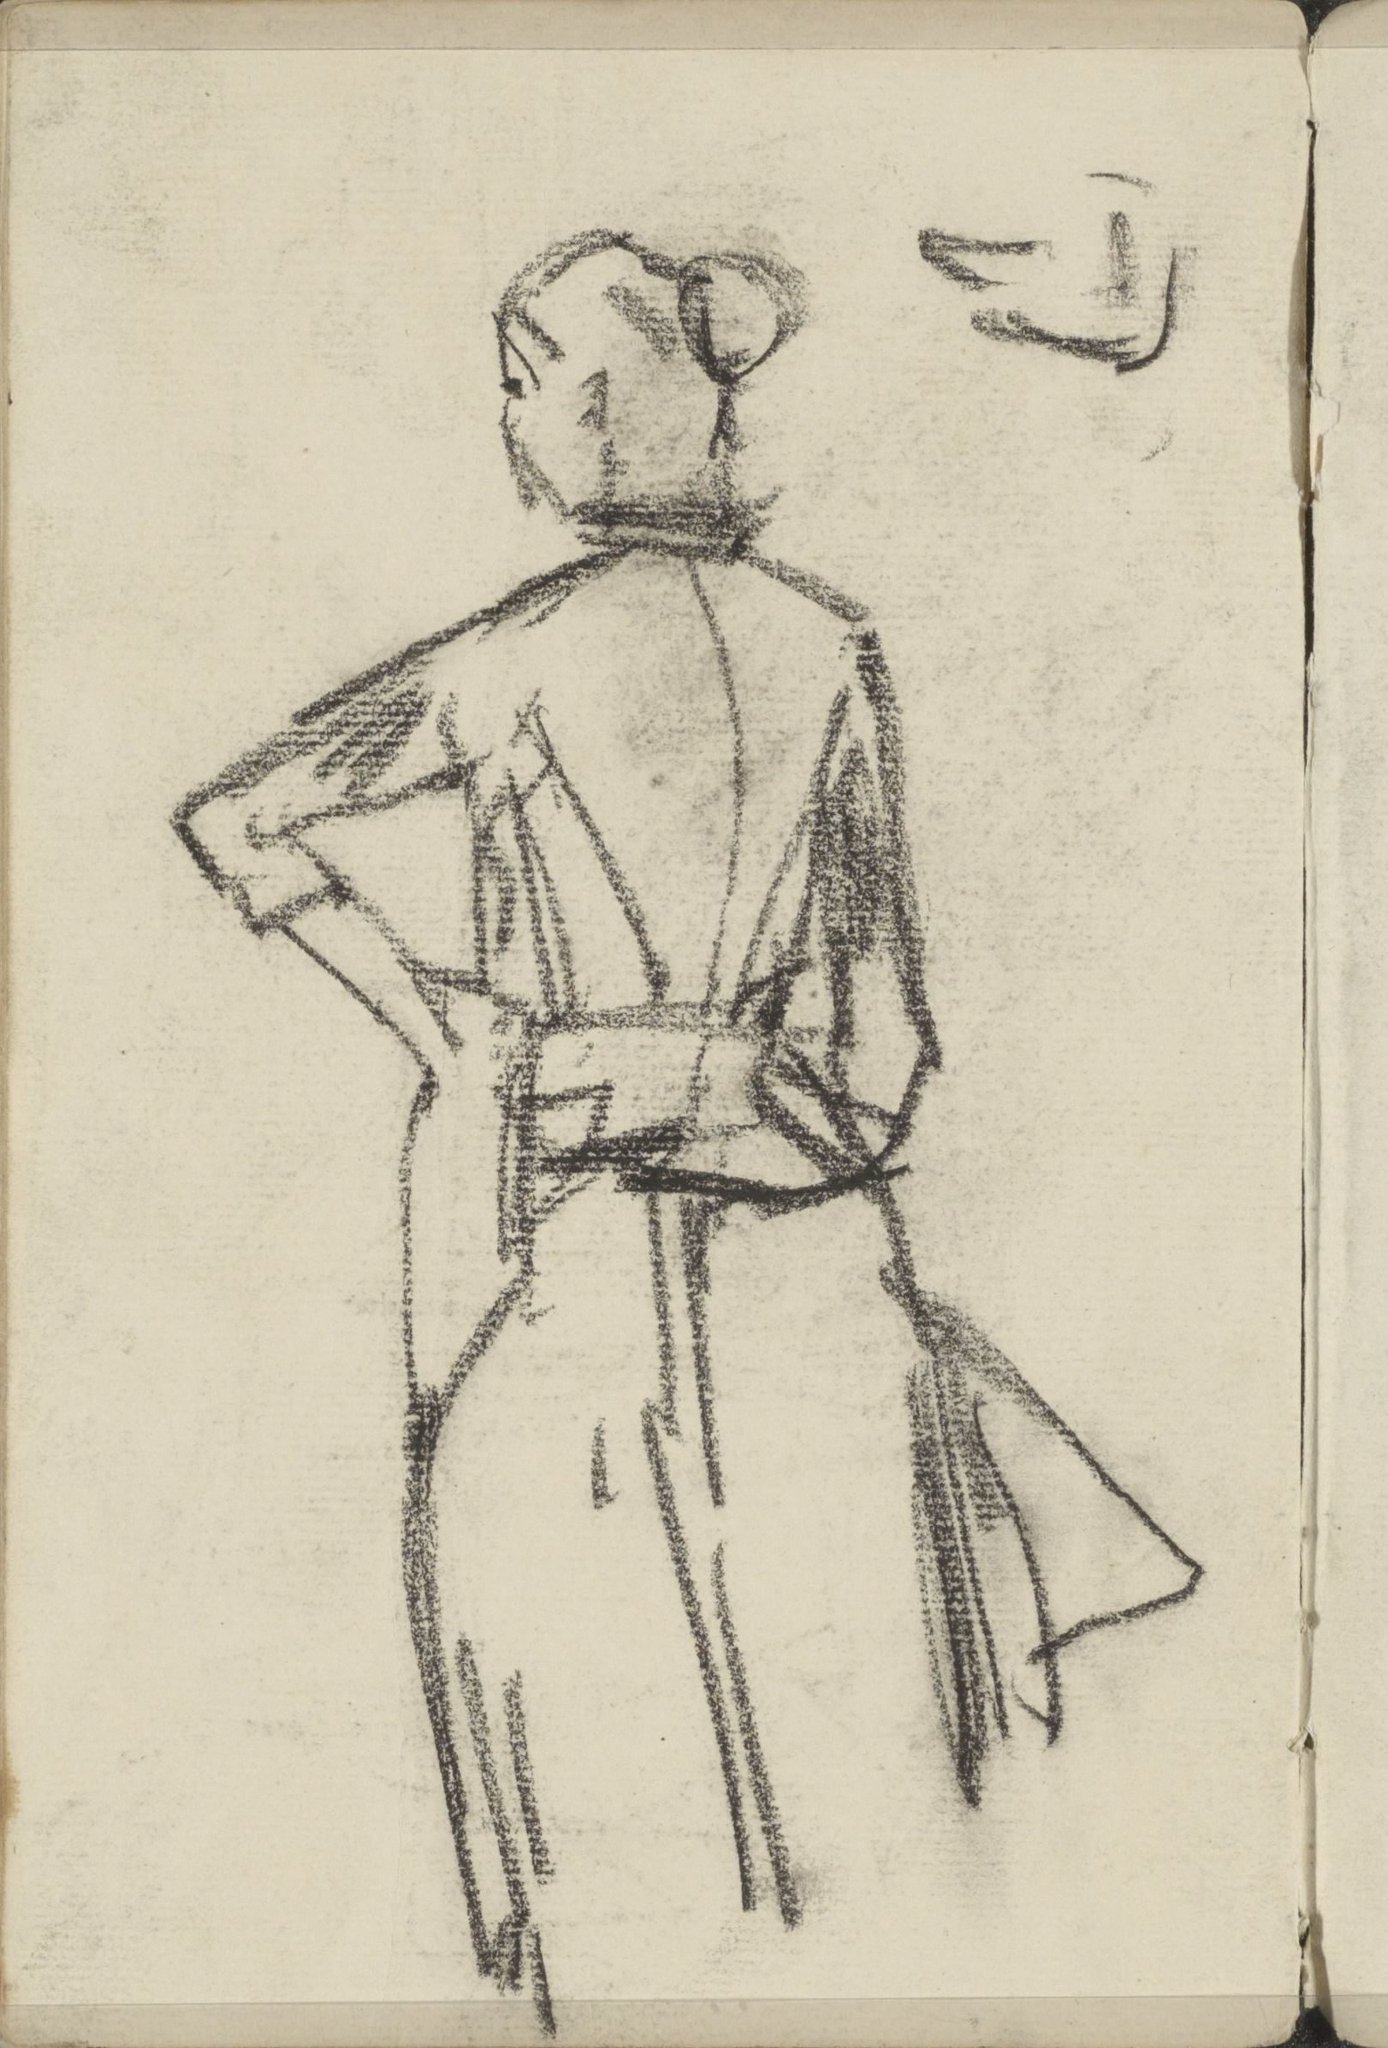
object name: sketchbook leaf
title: Jonge vrouw met een hand in haar zij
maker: george hendrik breitner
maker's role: draughtsman, painter, print maker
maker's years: 1857-1923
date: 1886-1903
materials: chalk, paper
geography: amsterdam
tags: hand on the hip, adolescent, young woman, maiden (+ back view)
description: Pagina 23 uit een schetsboek met 15 bladen.